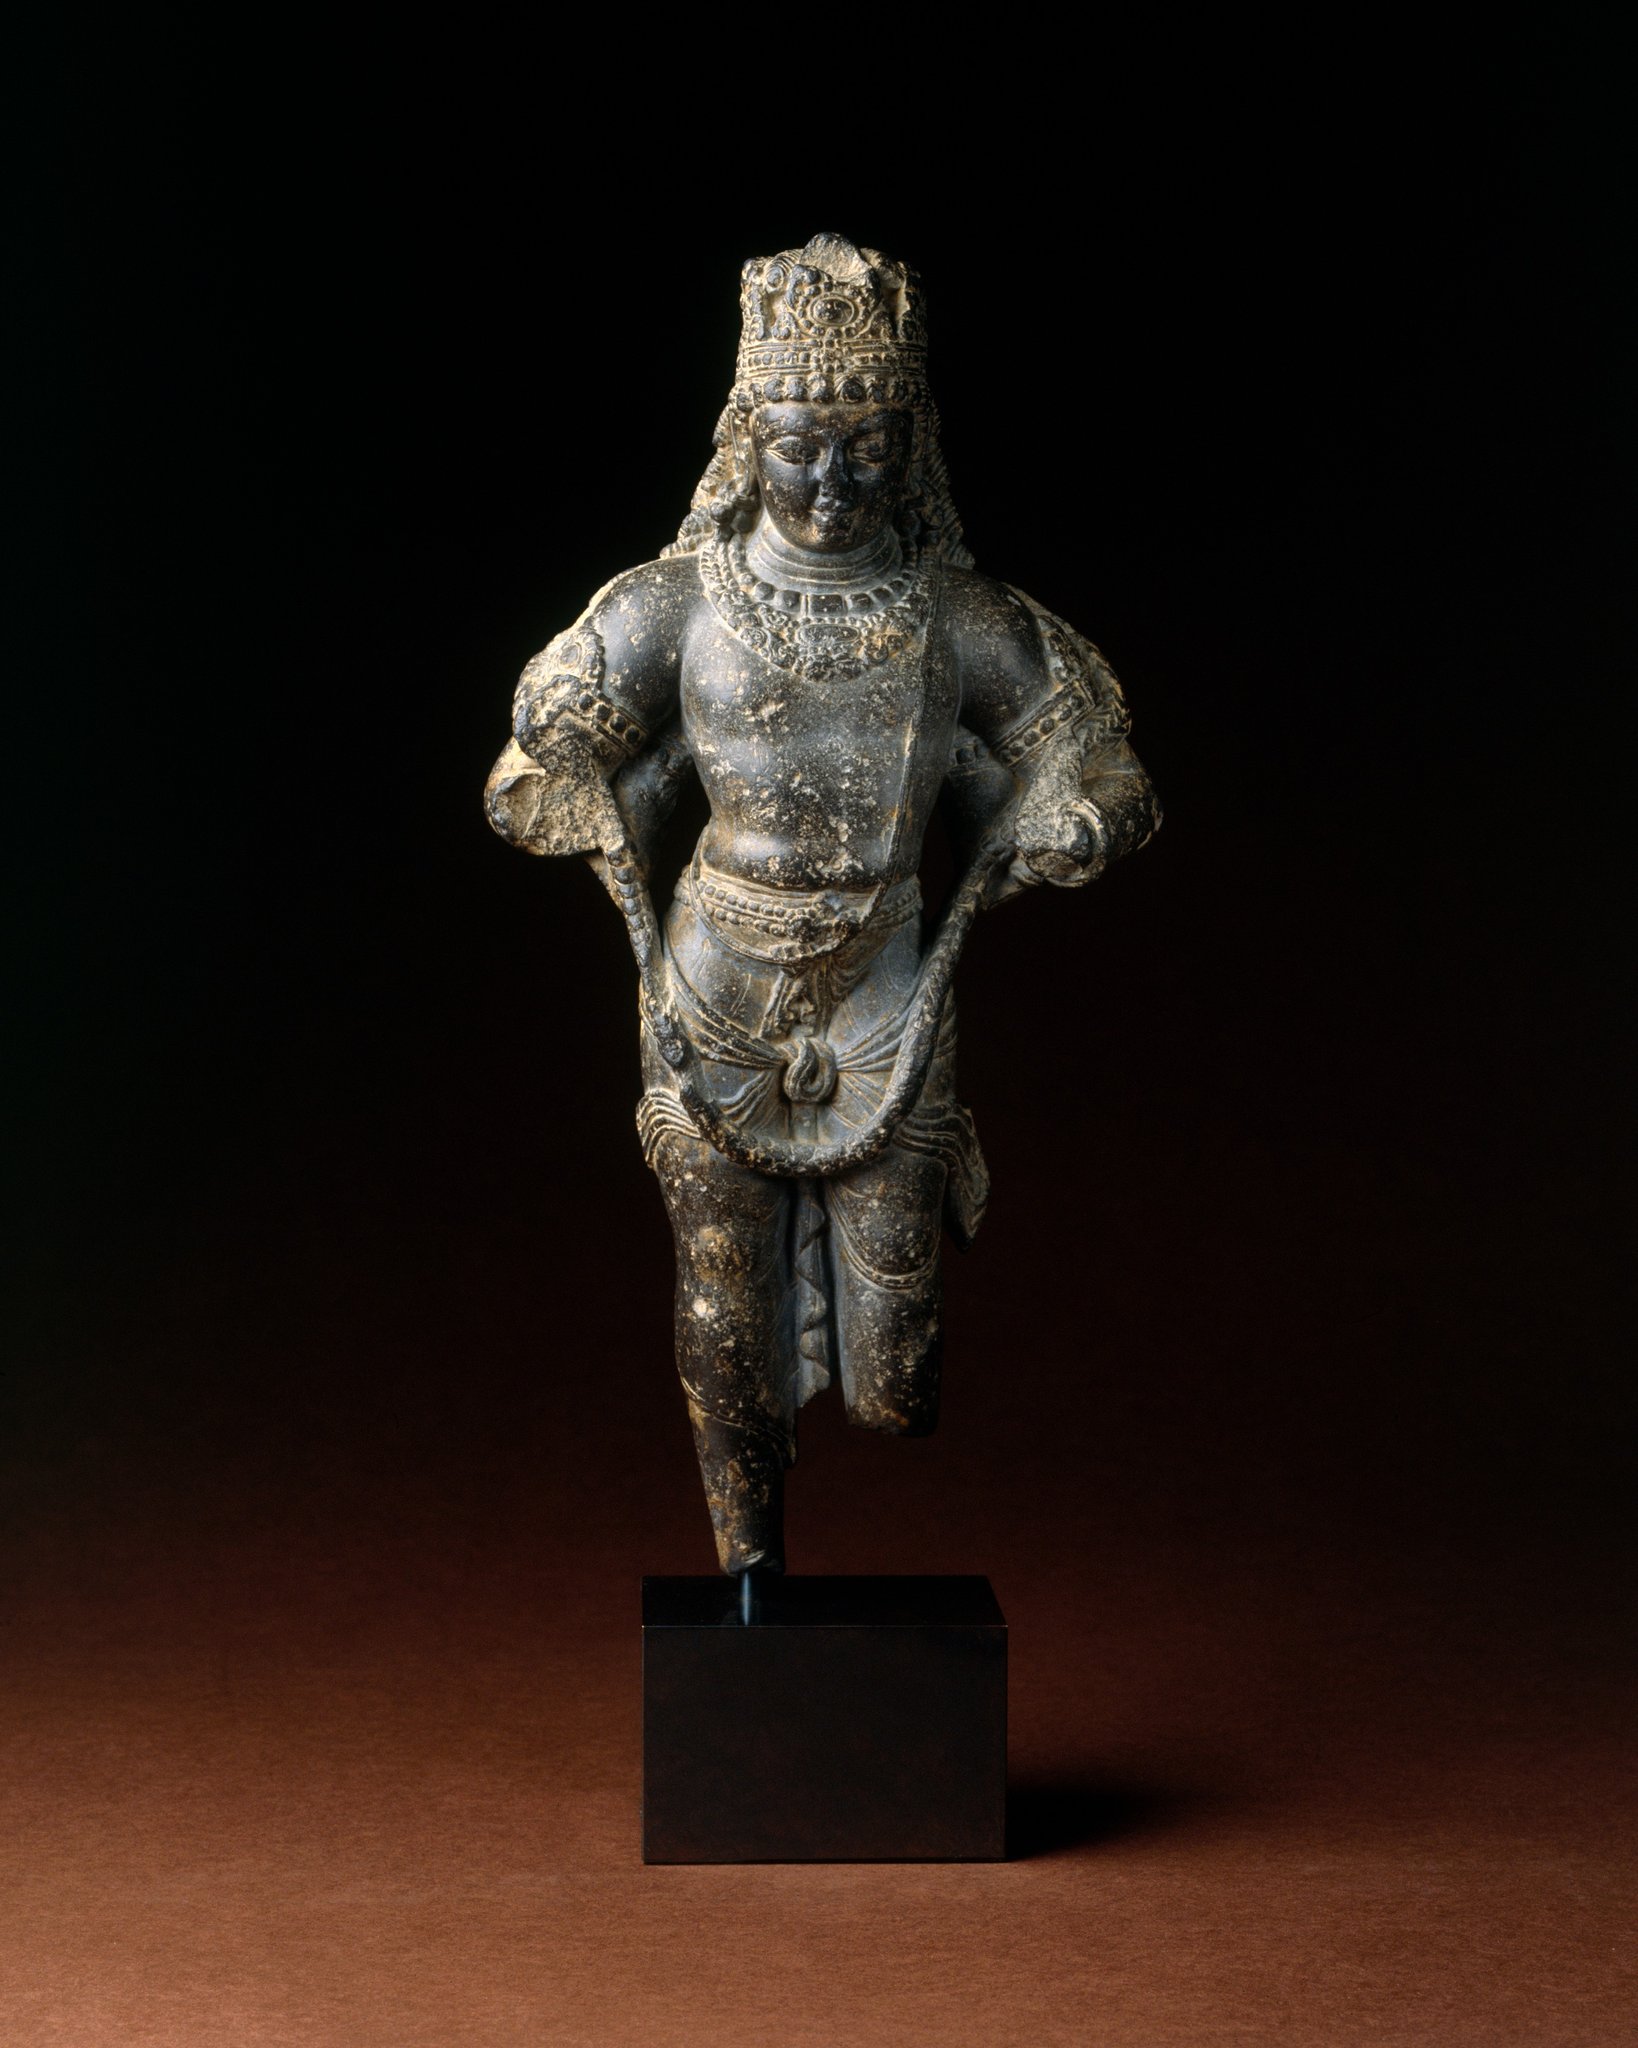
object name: figure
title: Vishnu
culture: kashmiri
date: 651-700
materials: stone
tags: kashmir,vishnu,hinduism